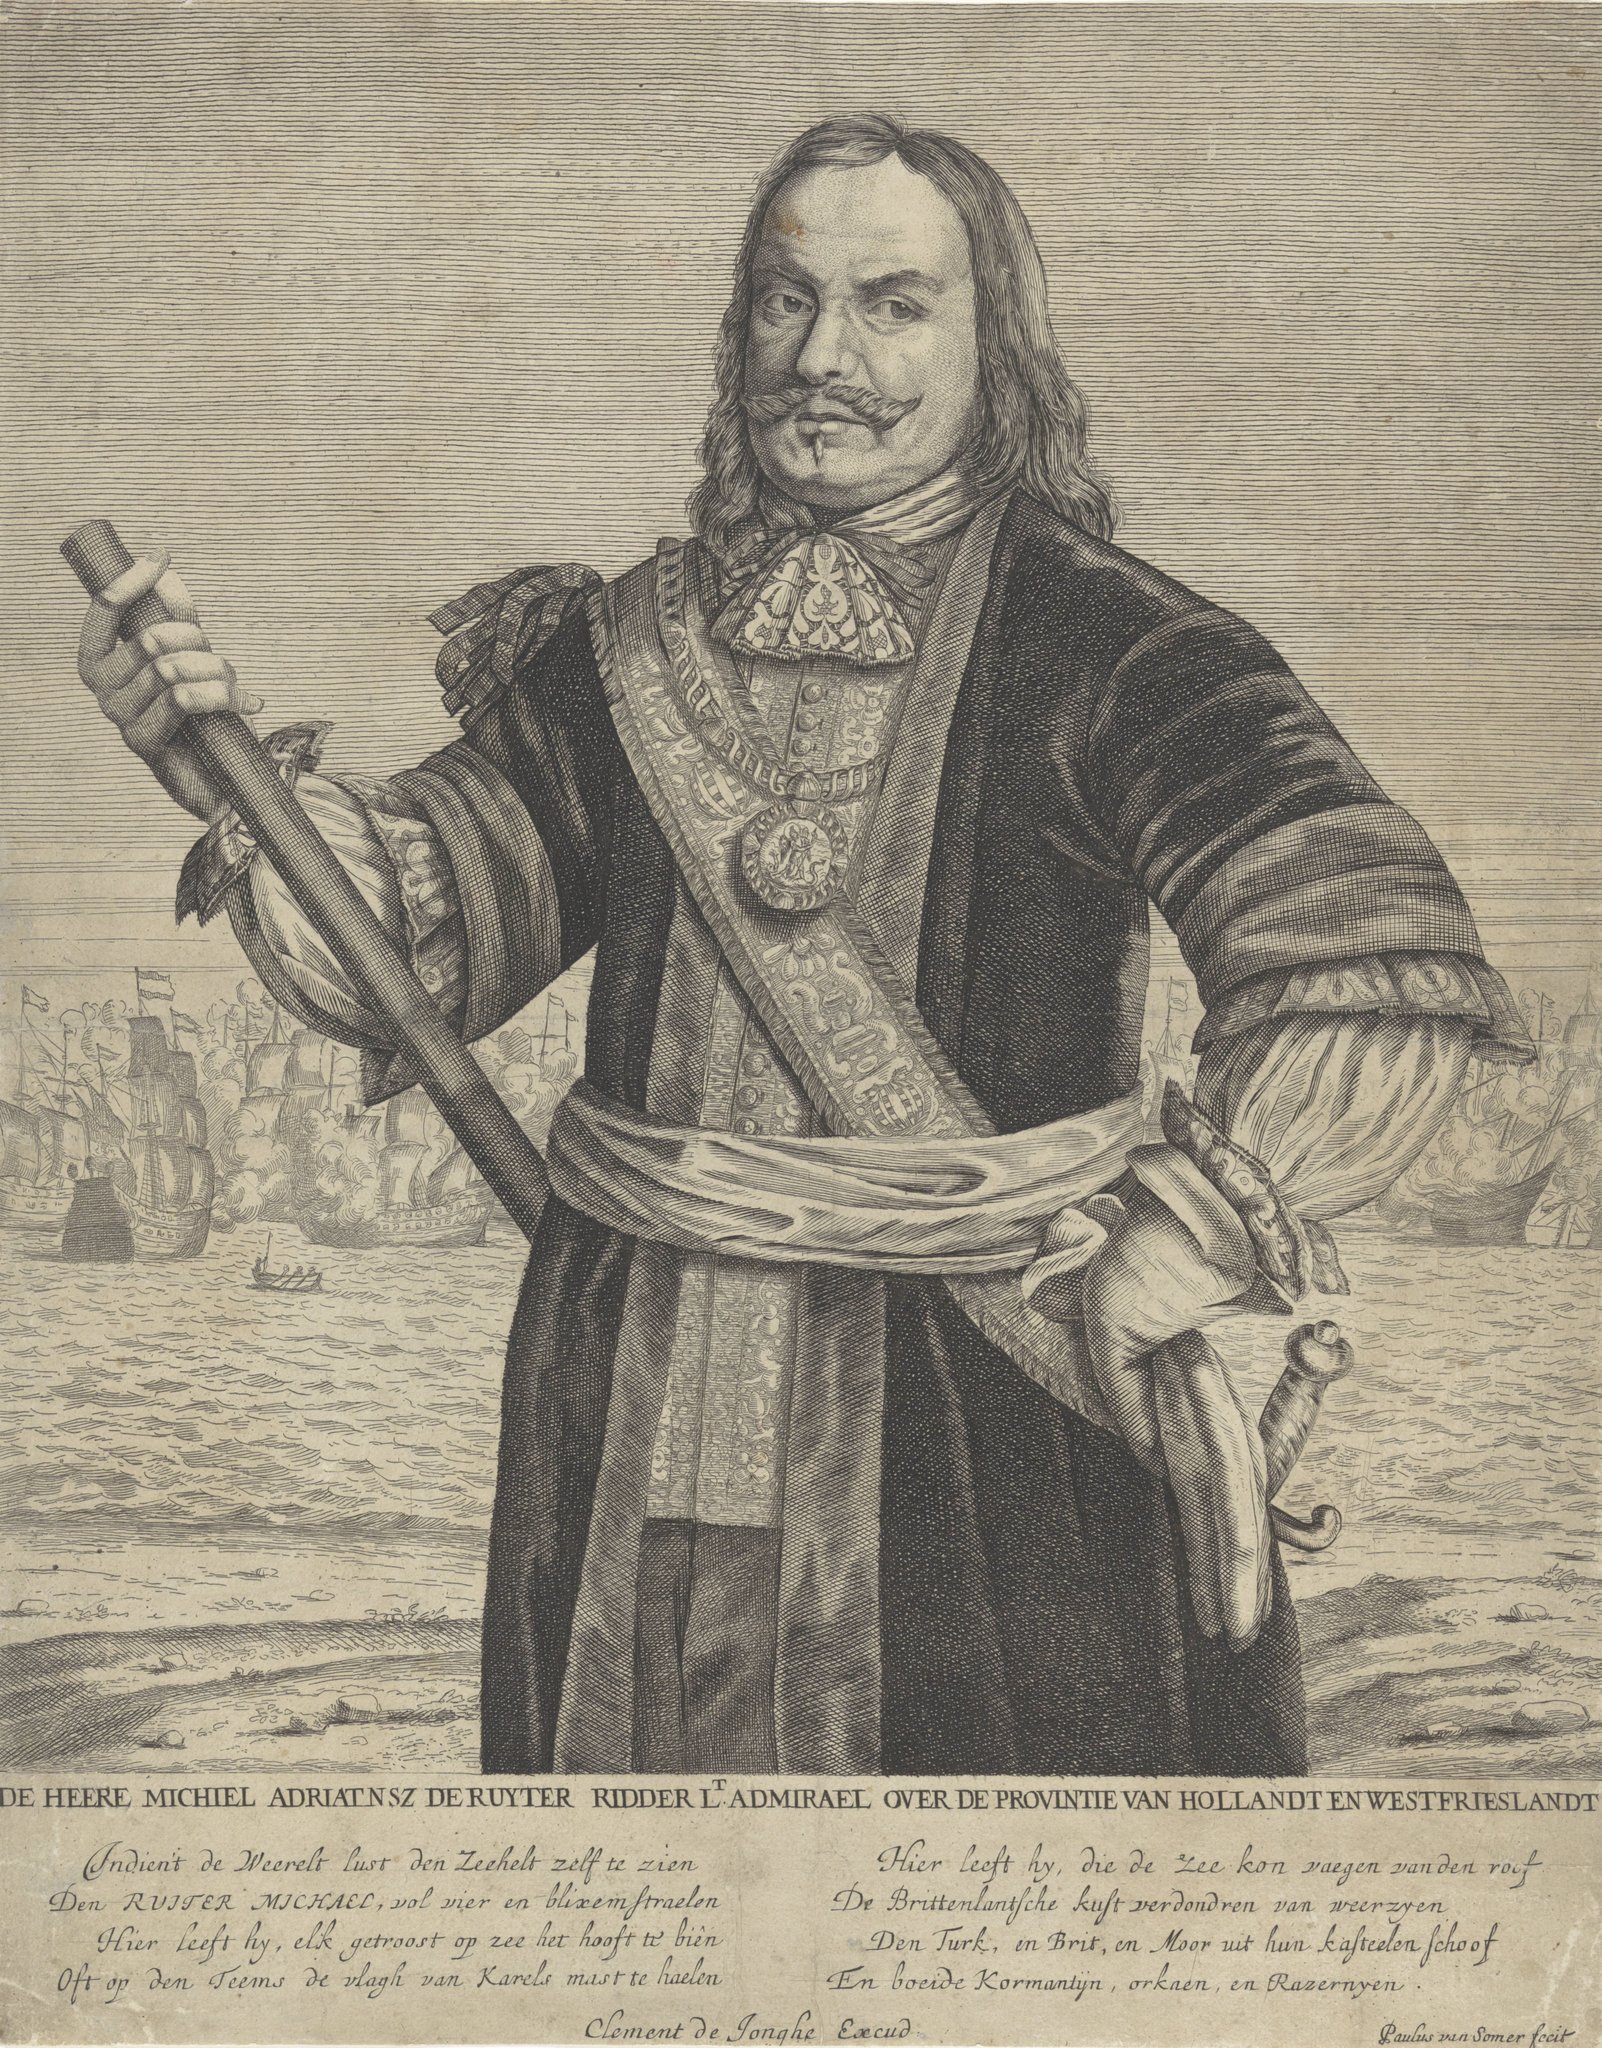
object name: print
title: Portret van Michiel Adriaenszoon de Ruyter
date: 1676-1696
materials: paper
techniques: engraving, etching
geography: amsterdam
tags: flushing, michiel adriaenszoon de ruyter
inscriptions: collector's mark: Lugt 2228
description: Portret van admiraal Michiel Adriaenszoon de Ruyter. Op de achtergrond een zeeslag. Onder het portret zijn naam en titel, daaronder een lofdicht in het Nederlands.